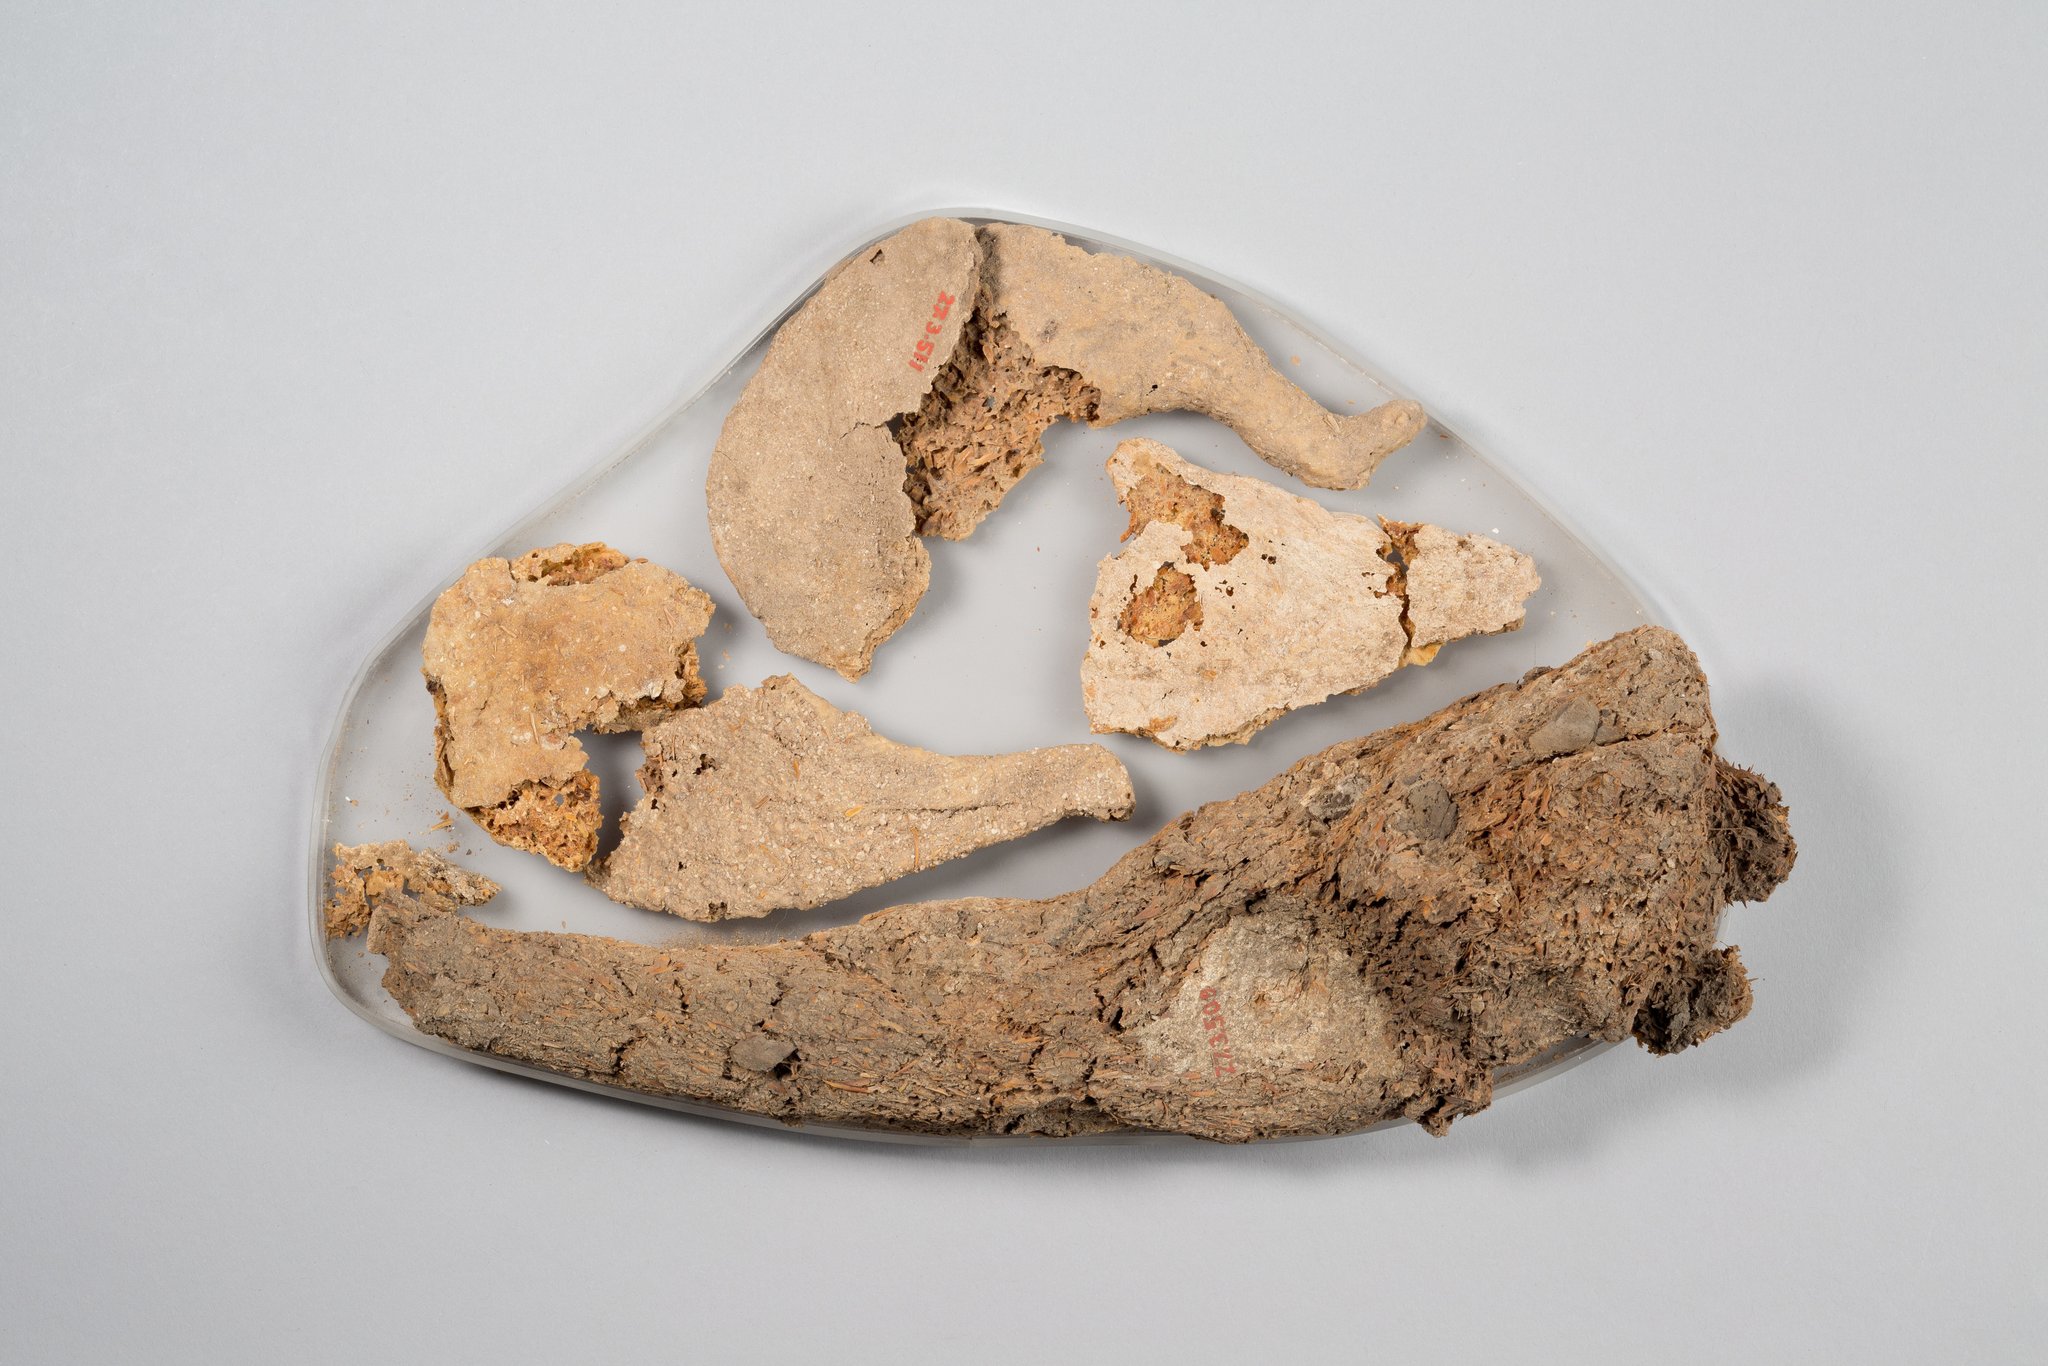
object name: food, bread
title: Bread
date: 1479-1458 BCE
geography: egypt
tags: bread